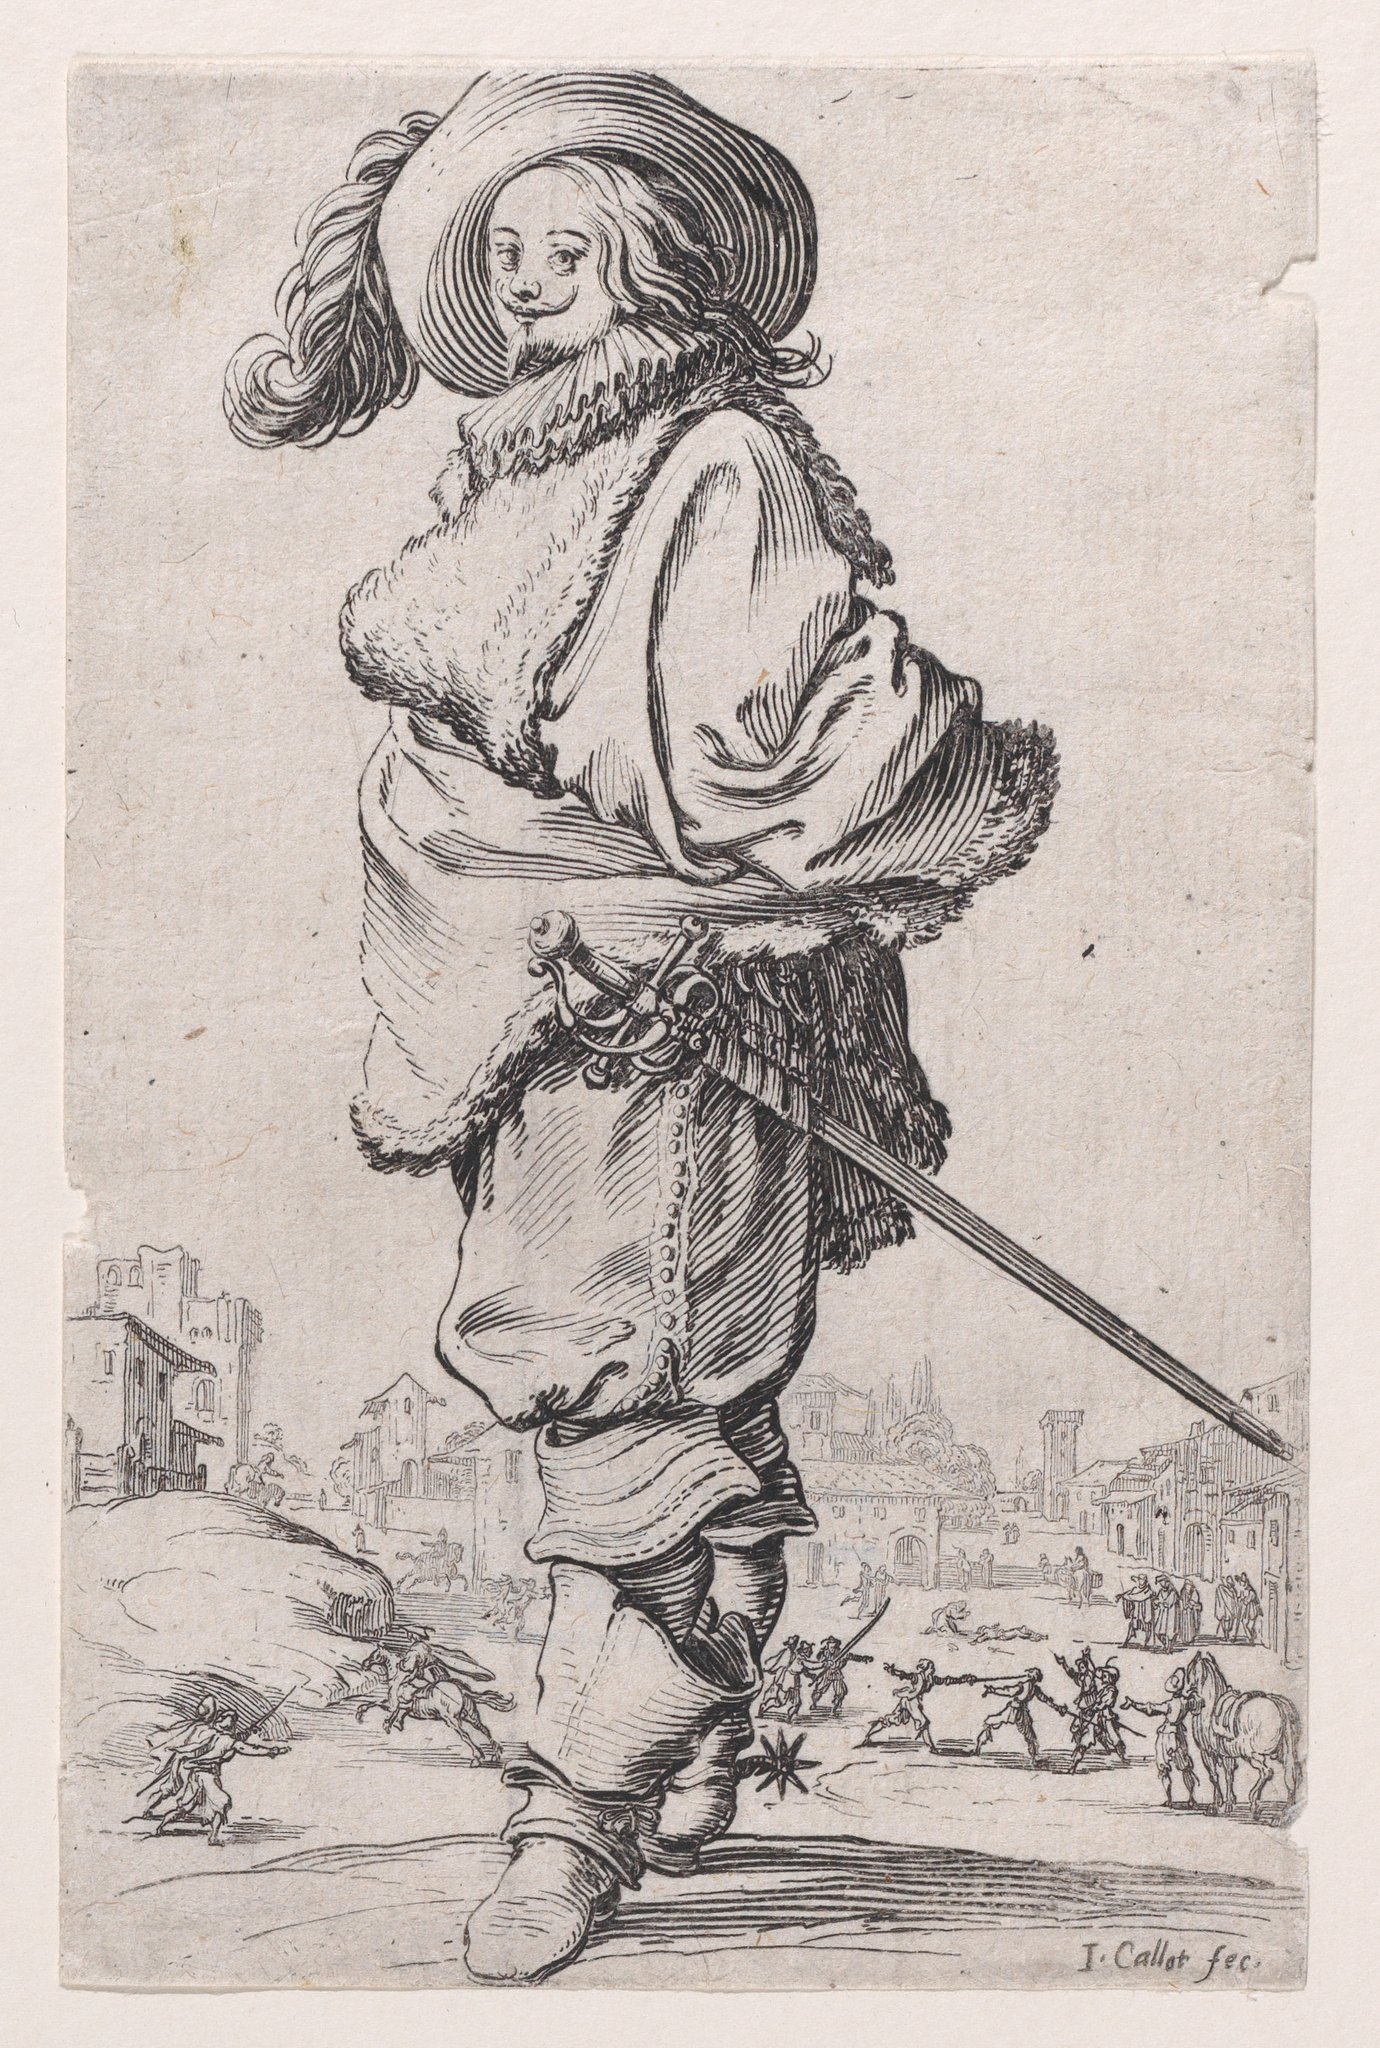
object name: print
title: Le Gentilhomme au Plastron de Fourrure (The Gentleman with a Fur Shirt Front), from "La Noblesse" (The Nobility)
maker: jacques callot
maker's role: artist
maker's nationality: french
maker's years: 1592-1635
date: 1623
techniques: etching